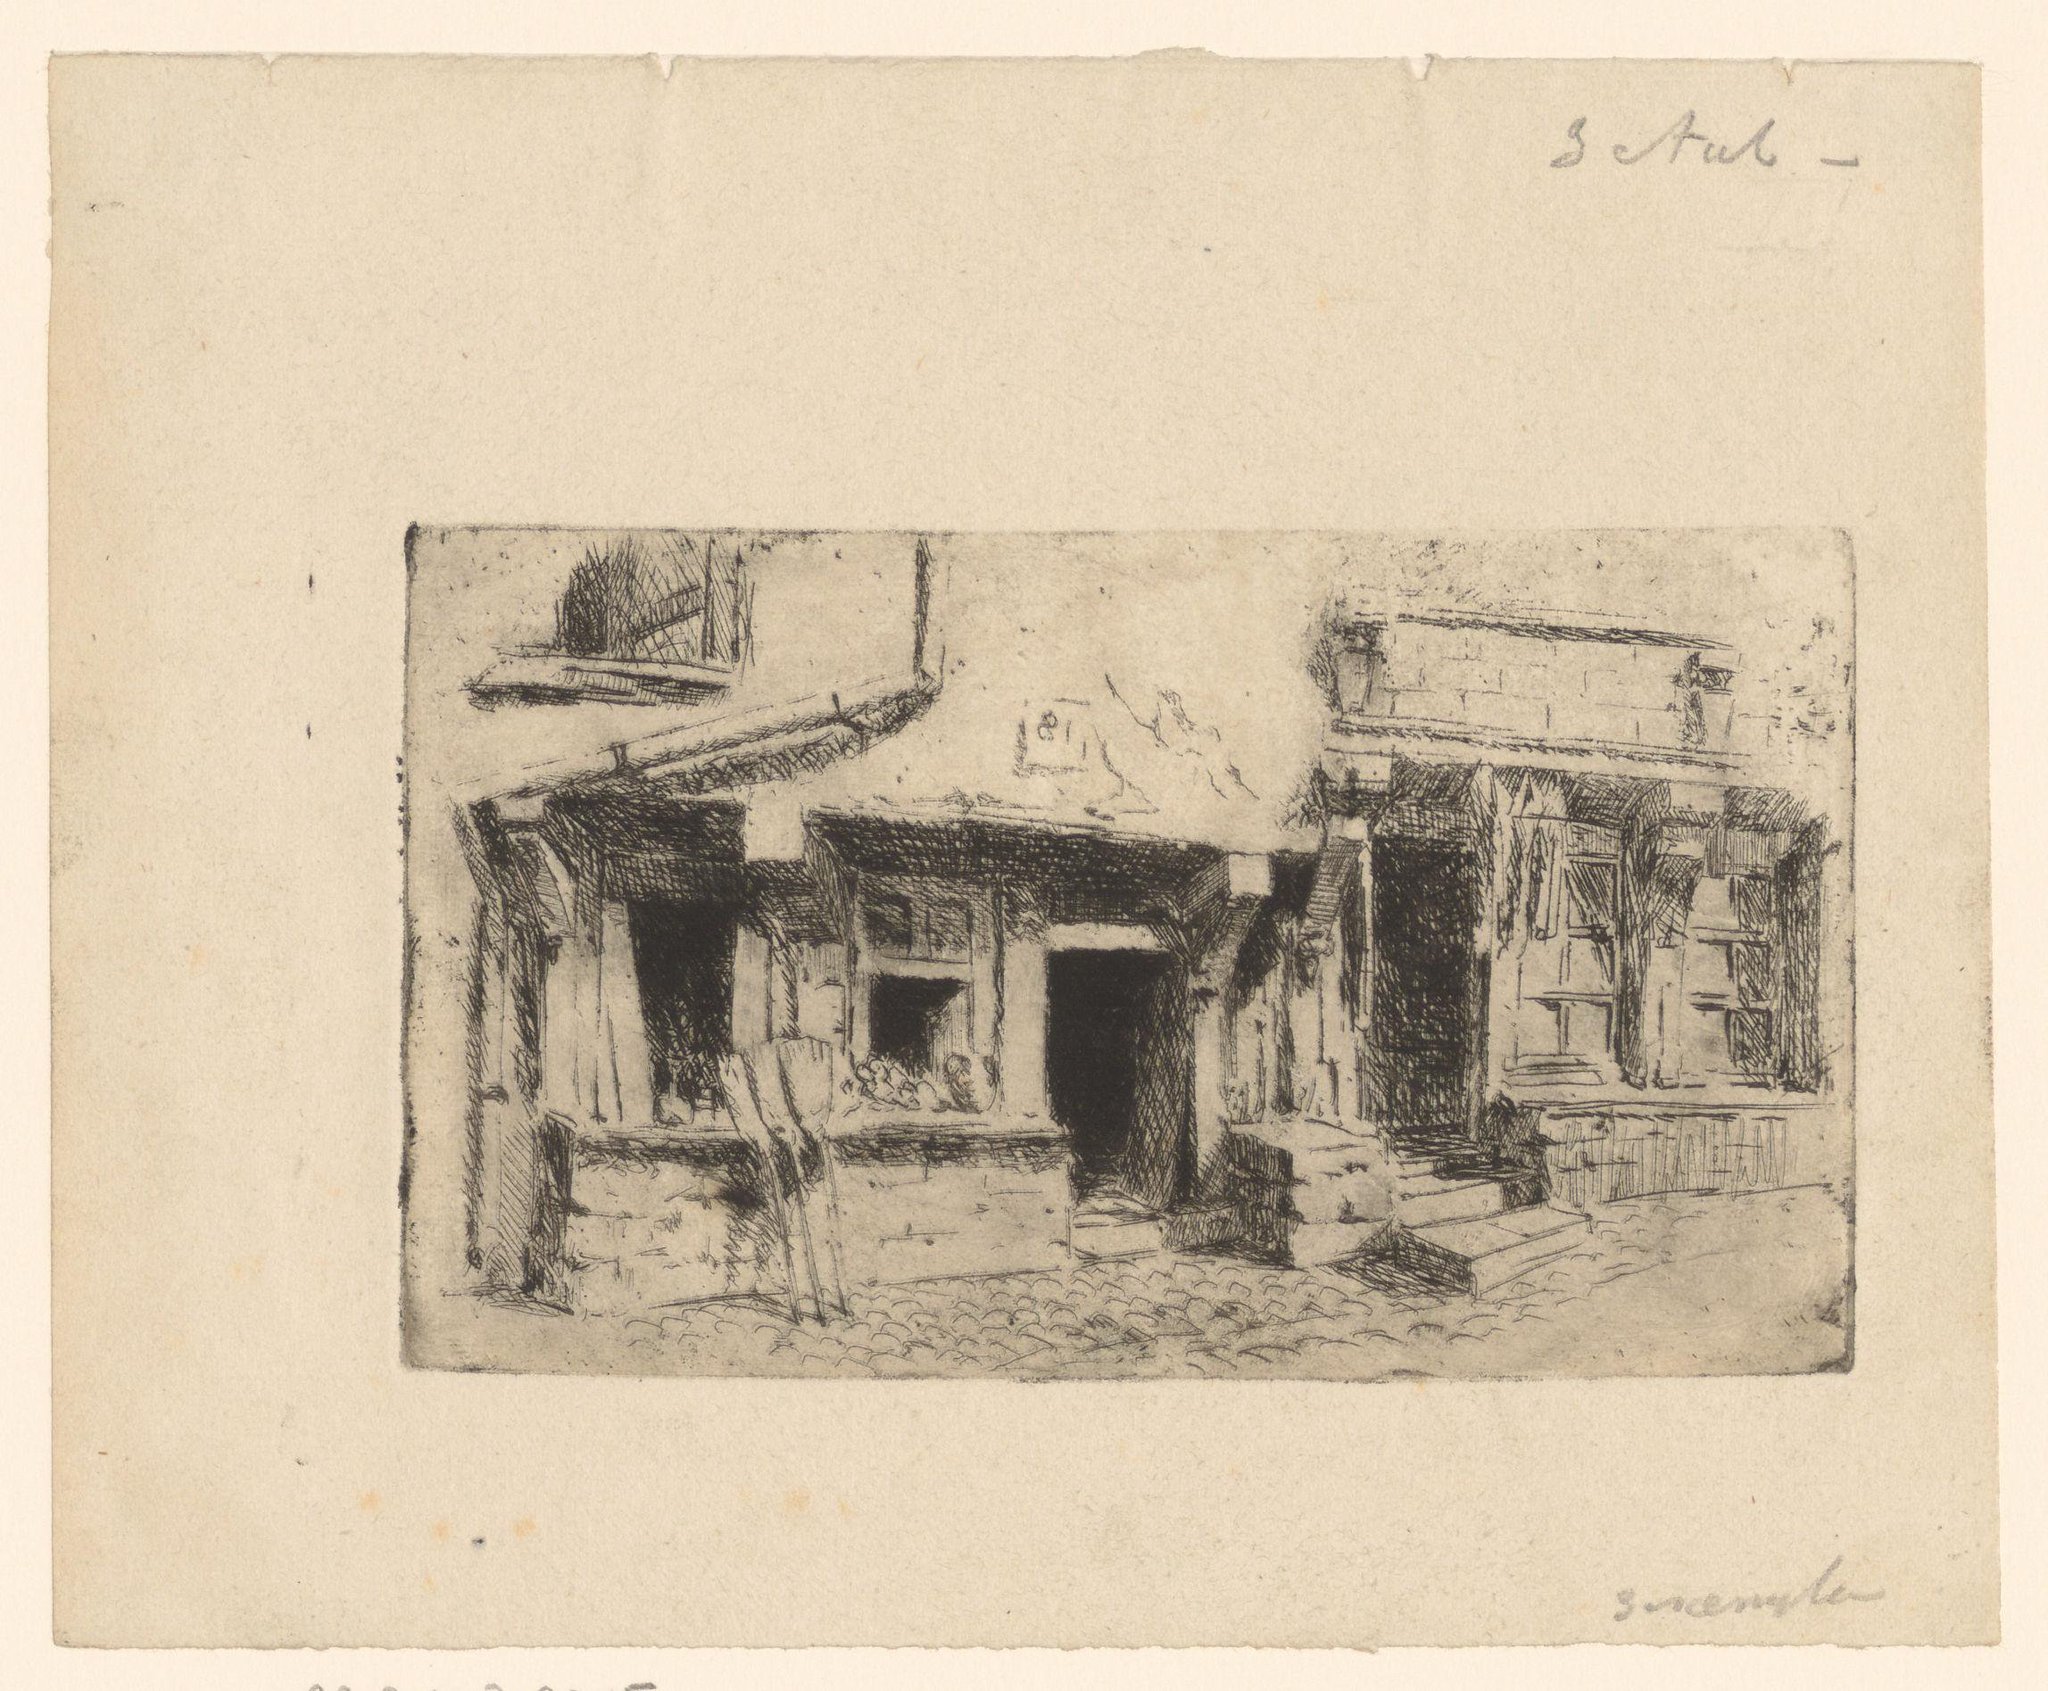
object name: print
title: Winkel in een straat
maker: william spread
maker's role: print maker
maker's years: 1846-1909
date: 1879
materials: paper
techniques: etching, intaglio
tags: shop, store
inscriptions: inscription: ‘3 etat’, collector's mark: Lugt 2228